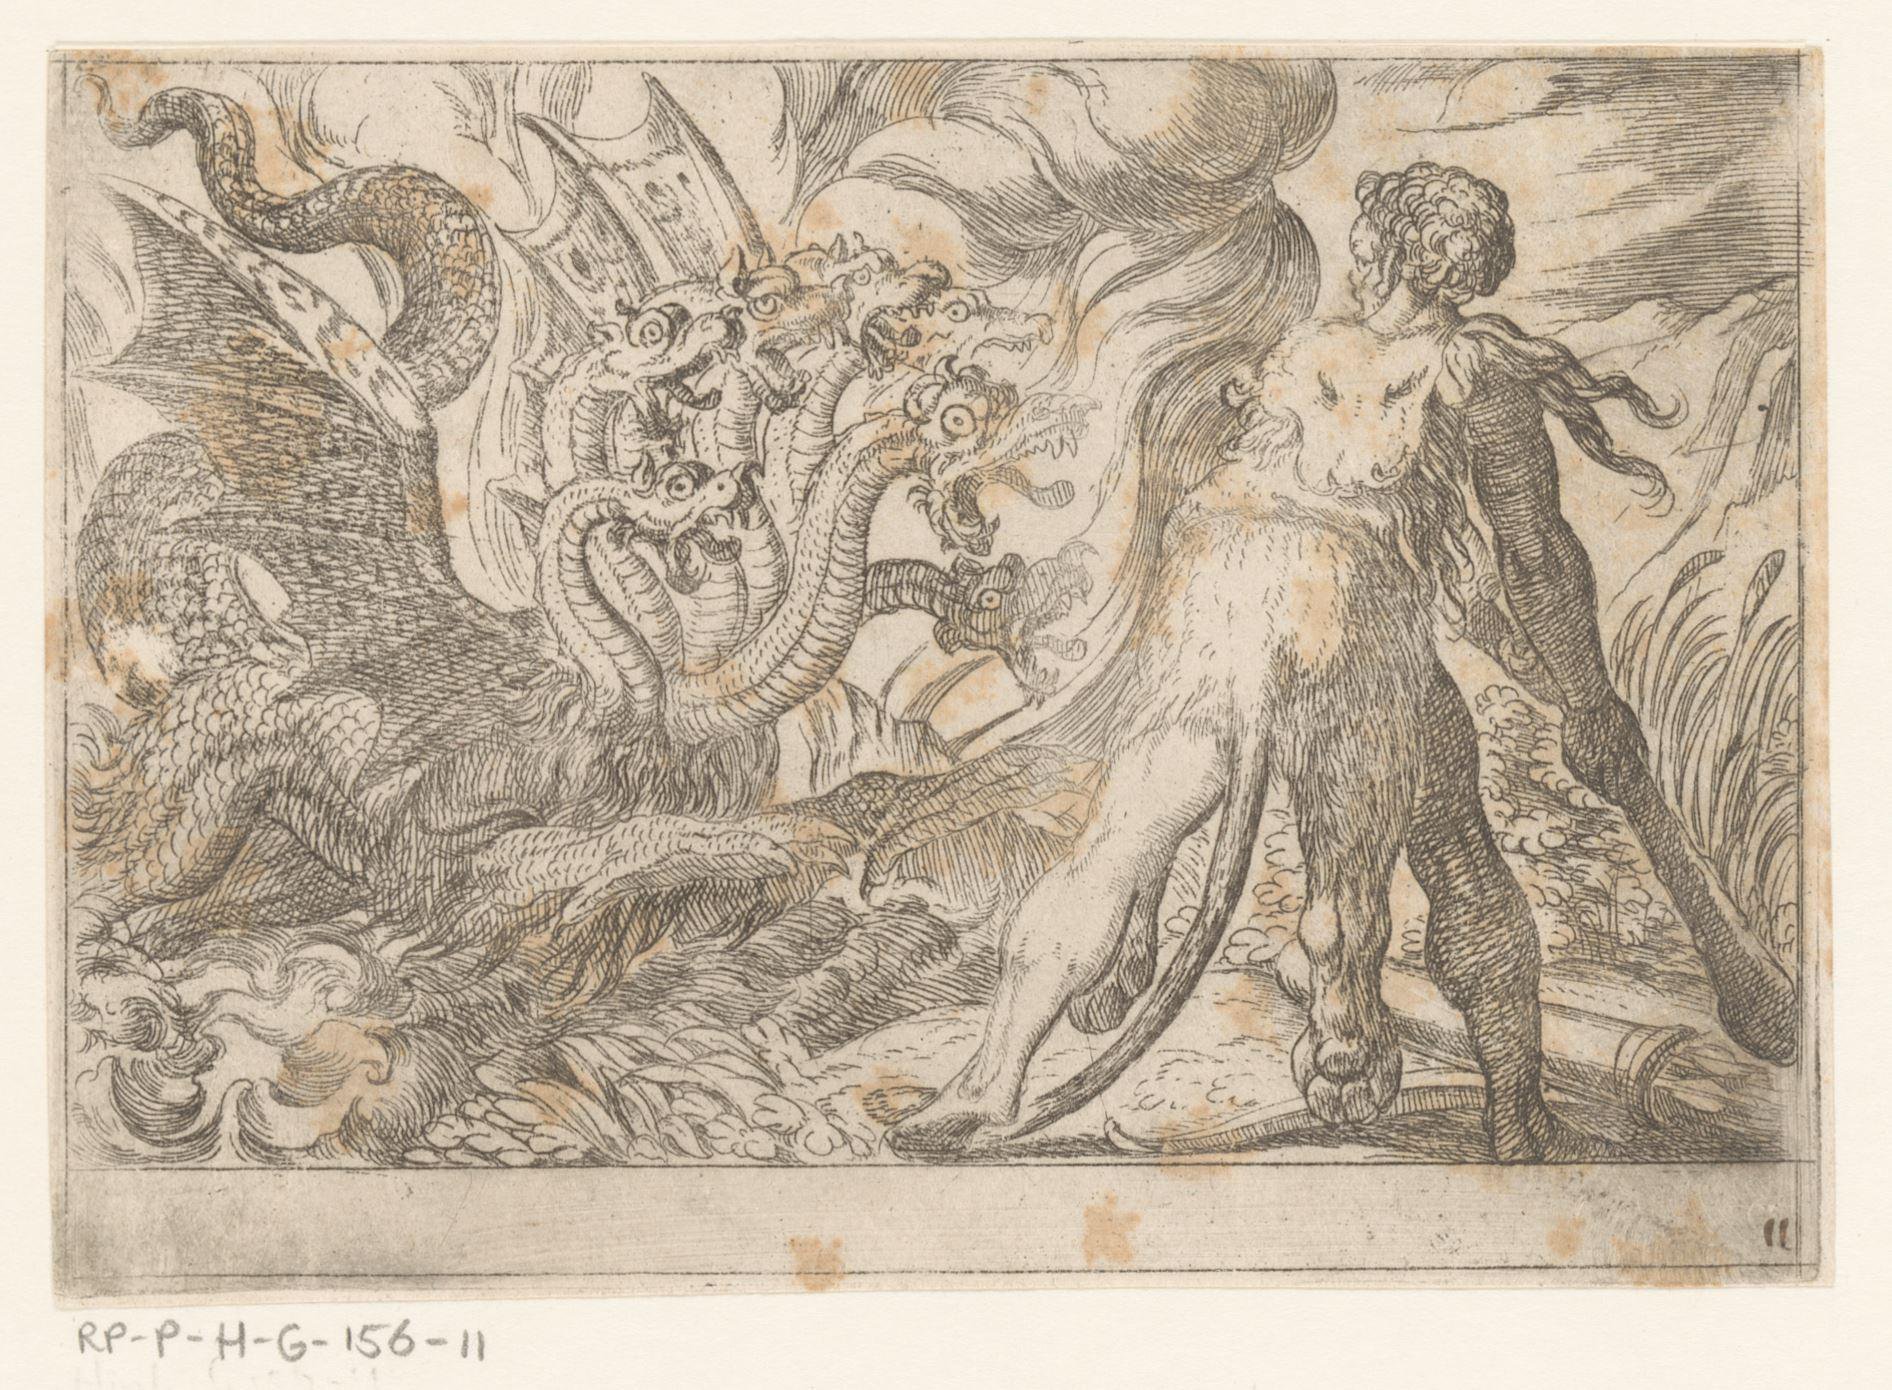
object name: print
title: Hercules in gevecht met de hydra van Lerna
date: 1608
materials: paper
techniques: etching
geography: rome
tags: (2) the hydra of lerna is killed by hercules, most important deeds of hercules: the twelve labours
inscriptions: collector's mark: ‘Hinloopen’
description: Deze prent maakt deel uit van een reeks van 12 prenten van de twaalf werken van Hercules (+ titelprent).